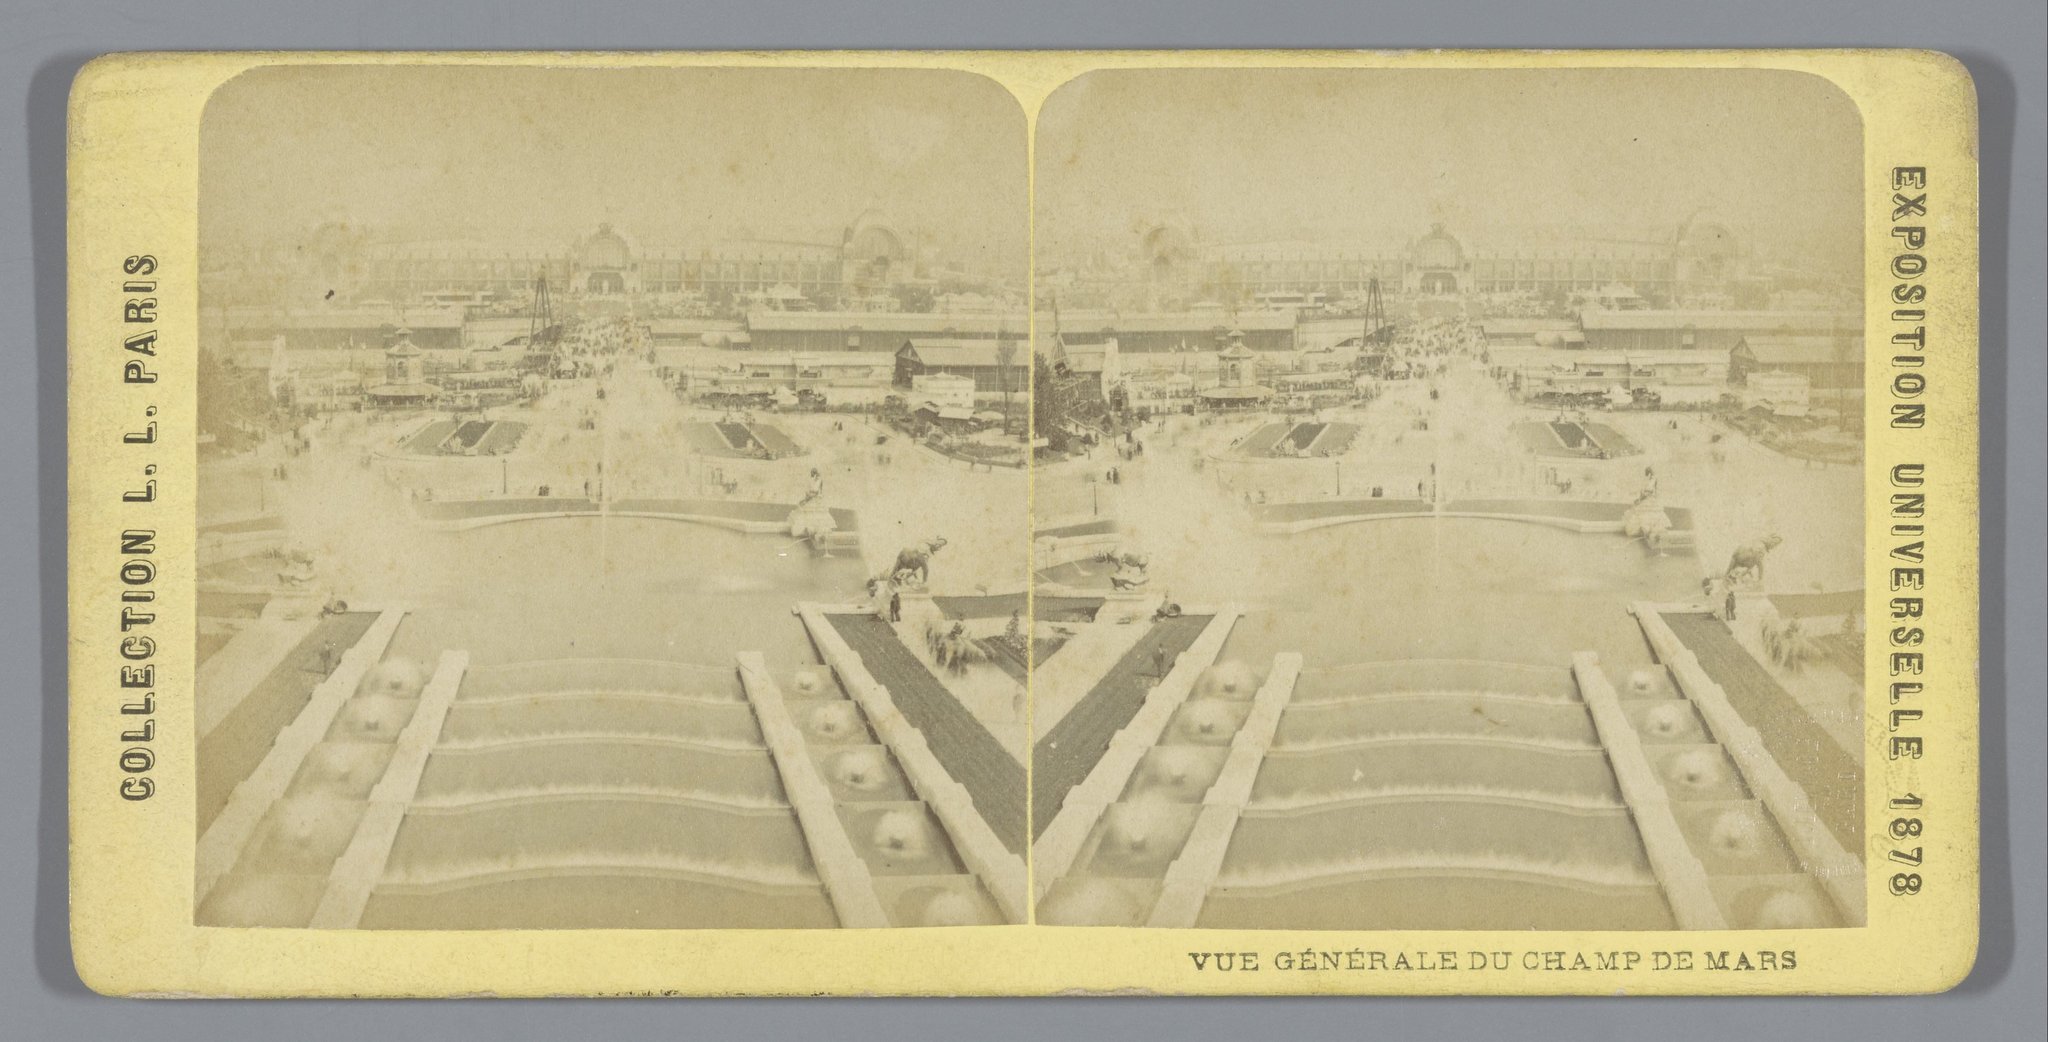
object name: stereograph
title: Vue générale du Champ de Mars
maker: Anonymous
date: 1878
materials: cardboard, paper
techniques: albumen print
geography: paris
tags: world fair, world exhibition, public gardens, park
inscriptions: inscription: ‘L = 30/ J3’, check stamp: ‘PHOTOGRAPHIE SUR VERRE & SUR PAPIER/ J. LEVY & CIE/ PARIS’